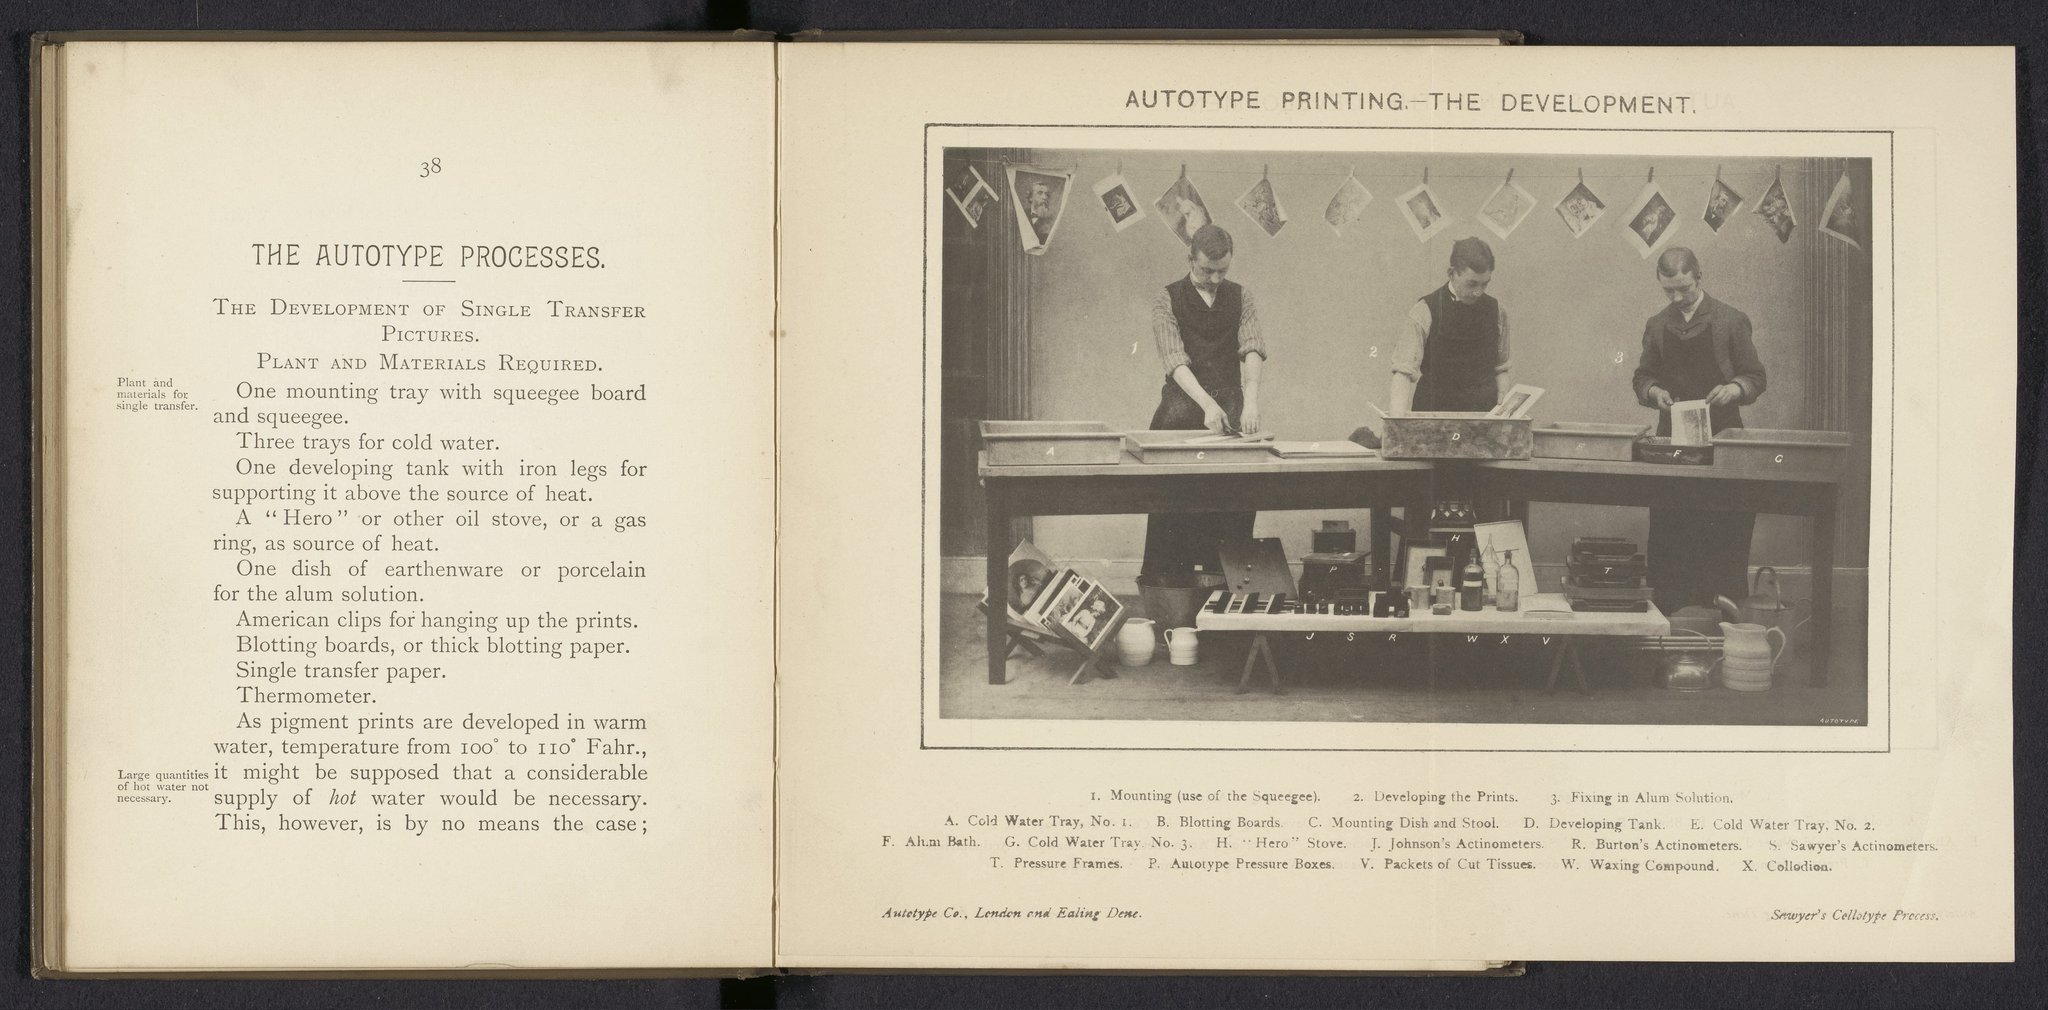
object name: photomechanical print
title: Proces van het ontwikkelen van vermoedelijk een kooldruk gedemonstreerd door drie mannen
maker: Anonymous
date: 1885-1895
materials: paper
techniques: photograph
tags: developing ~ film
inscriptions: inscription: ‘I. Mounting (use of the Squeegee). 2. Developing Prints. 3. Fixing in Alum Solution. A. Cold Water Tray, No. I. B. Blotting Boards. C. Mounting Dish and Stool. D. Developing Tank. E. Cold Water Tray No. 2. F. Alum Bath G. Cold Water Tray No. 3. H. “Hero” Stove. J. Johnson's Actinometers. R. Burton's Actinometers. S. Sawyer's Actinometers. T. Pressure Frames. P. Autotype Pressure Boxes. V. Packets of Cut Tissues. W. Waxing Compound. X. Collodion.’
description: Prent op een uitvouwvel tegenover pagina 38.